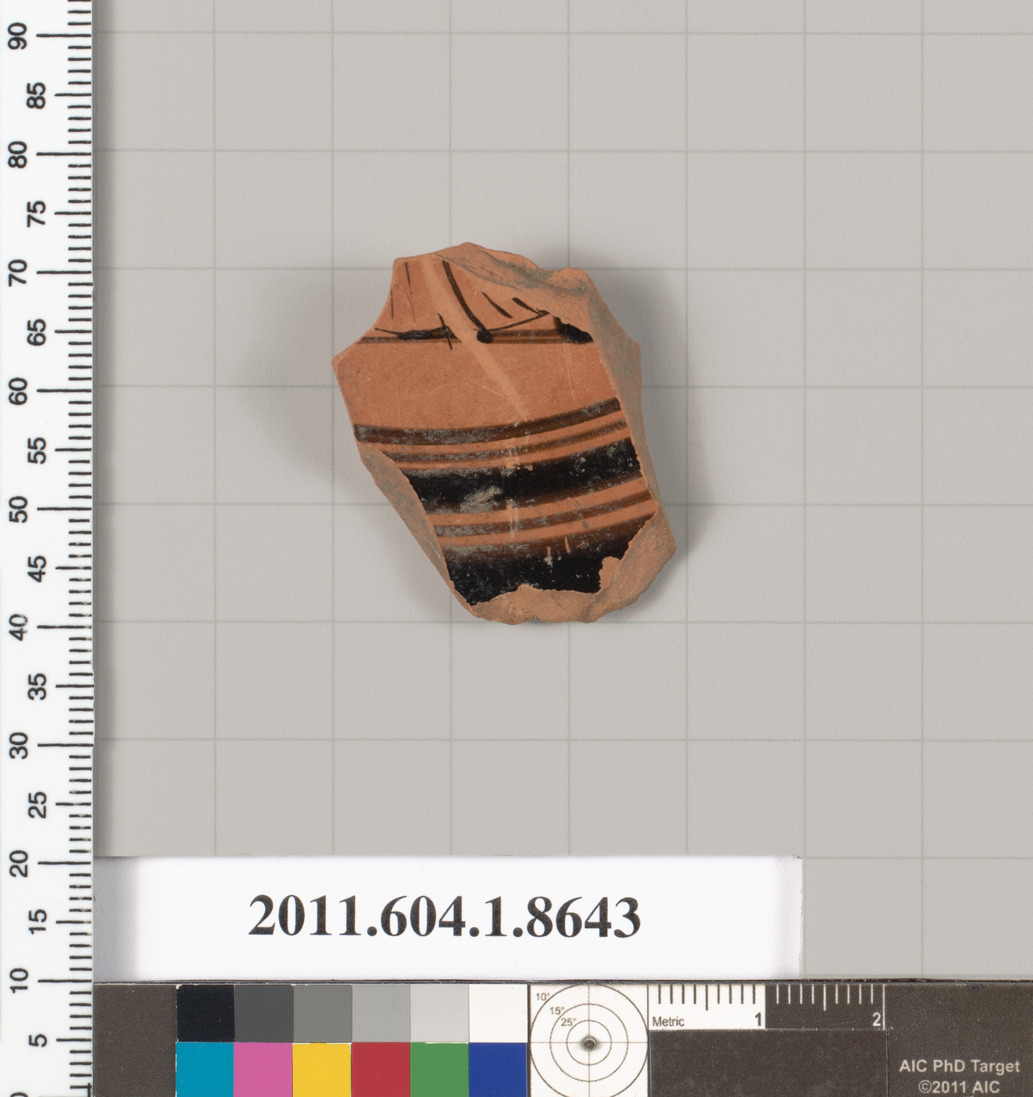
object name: kylix fragment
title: Terracotta fragment of a stemless kylix (drinking cup)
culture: greek, attic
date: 467-435 BCE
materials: terracotta